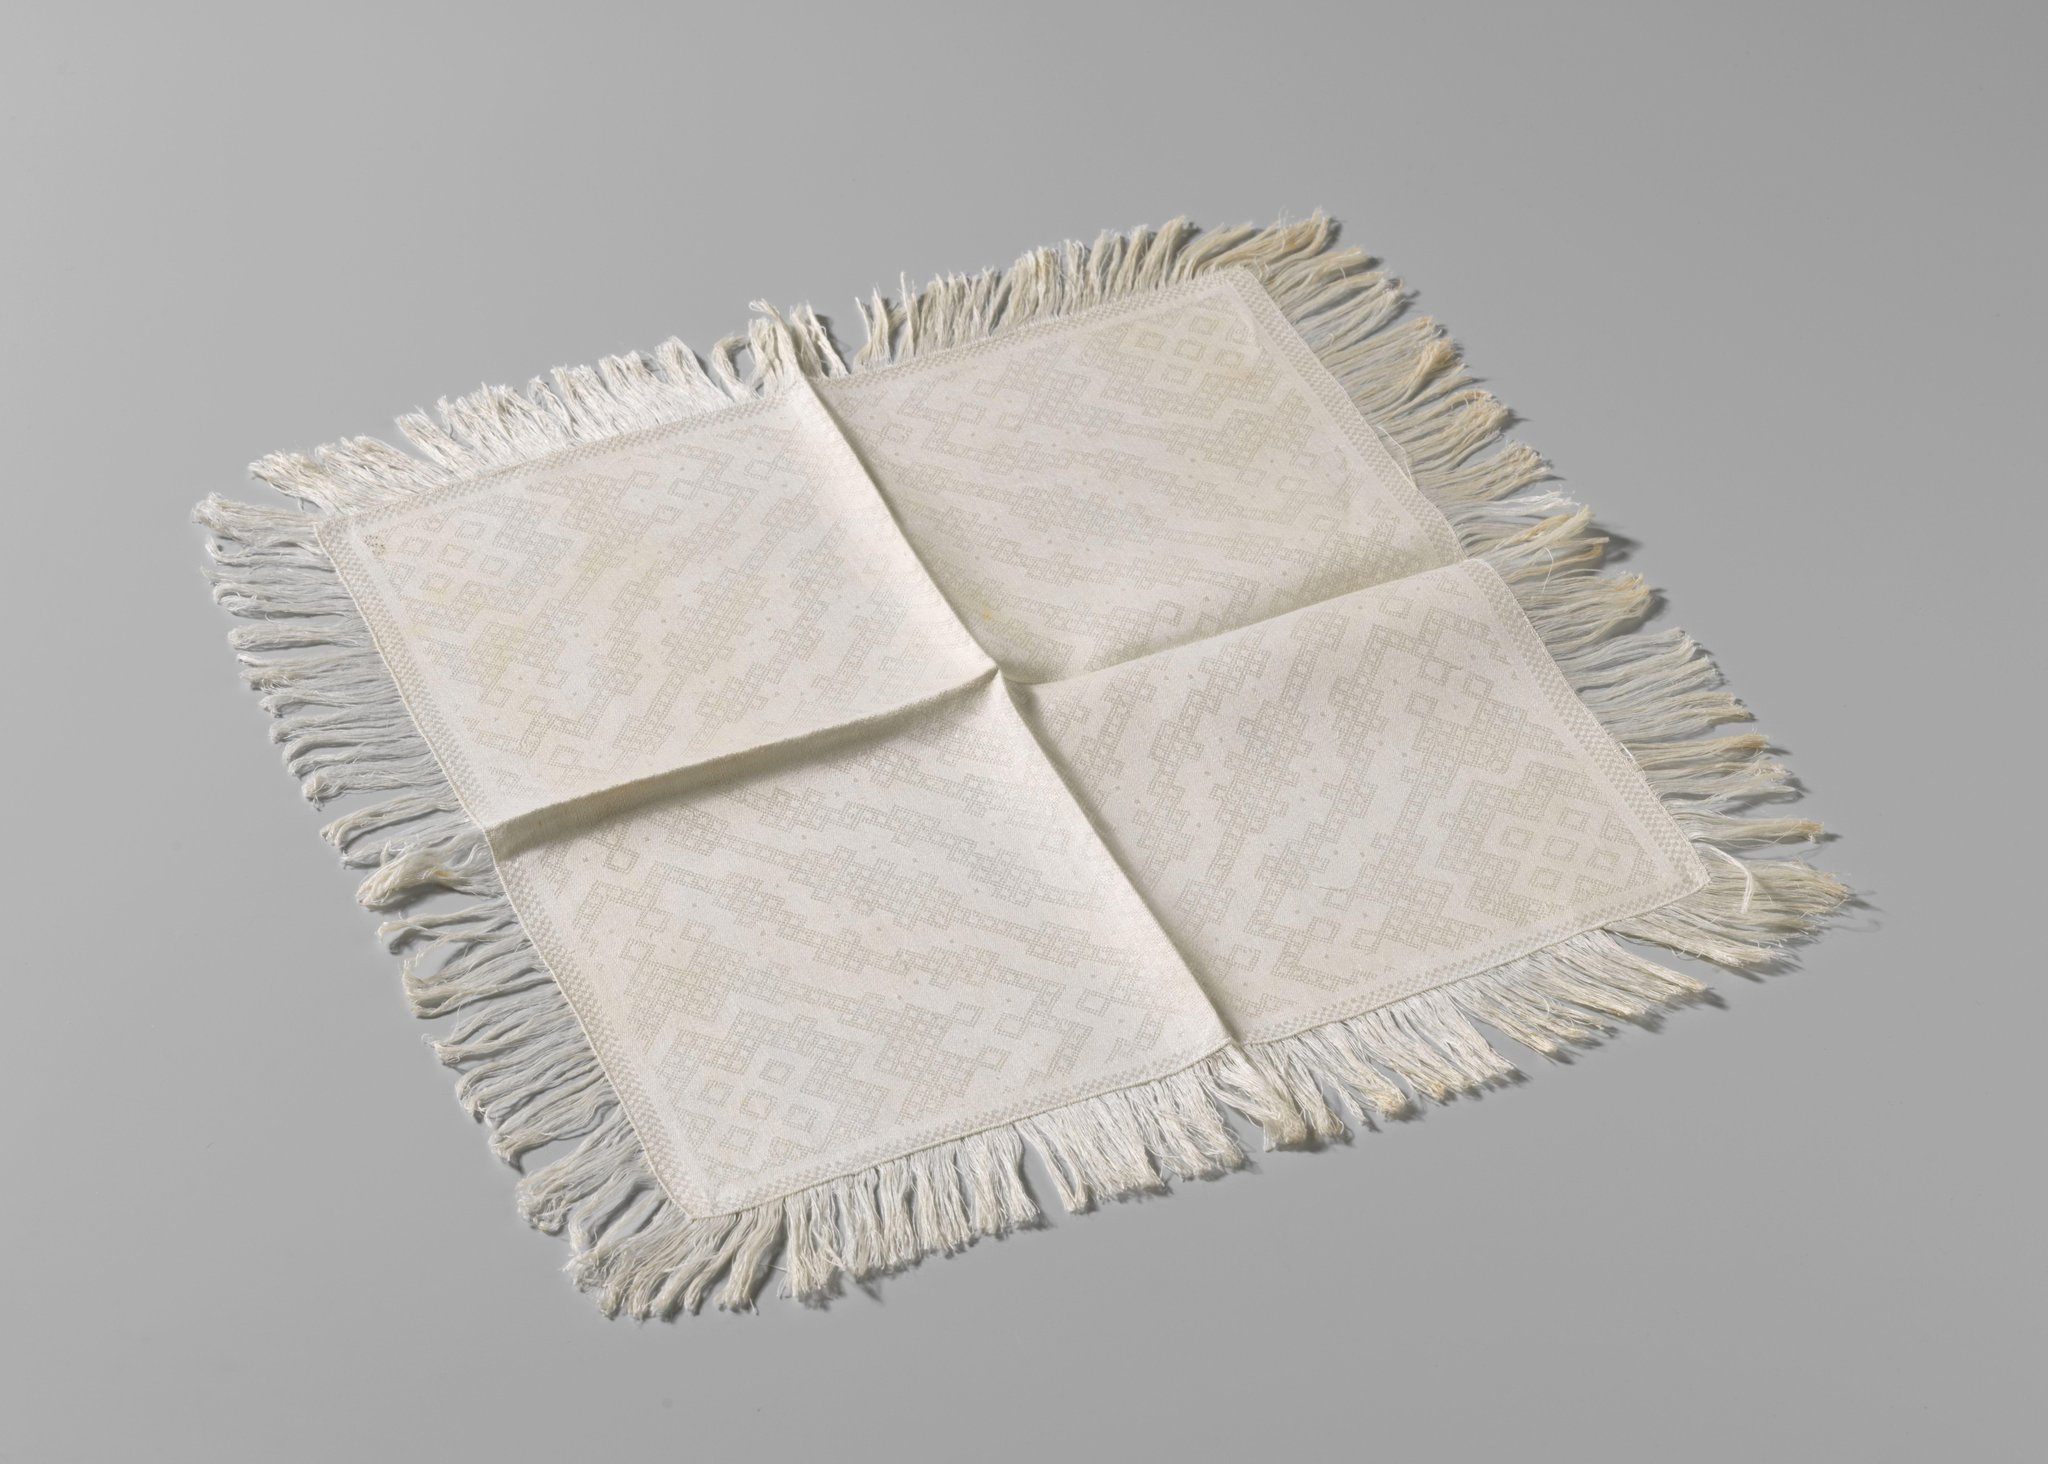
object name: vingerdoek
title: Vingerdoek met kruiswerk-patroon.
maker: Anonymous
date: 1905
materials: linen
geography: north brabant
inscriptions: mark: ‘S’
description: Vingerdoekje van linnen, met een "kruiswerk"patroon, imitatie van een vroeg 17de eeuws patroon. Rondom franje. Merk: bindgatletter S.